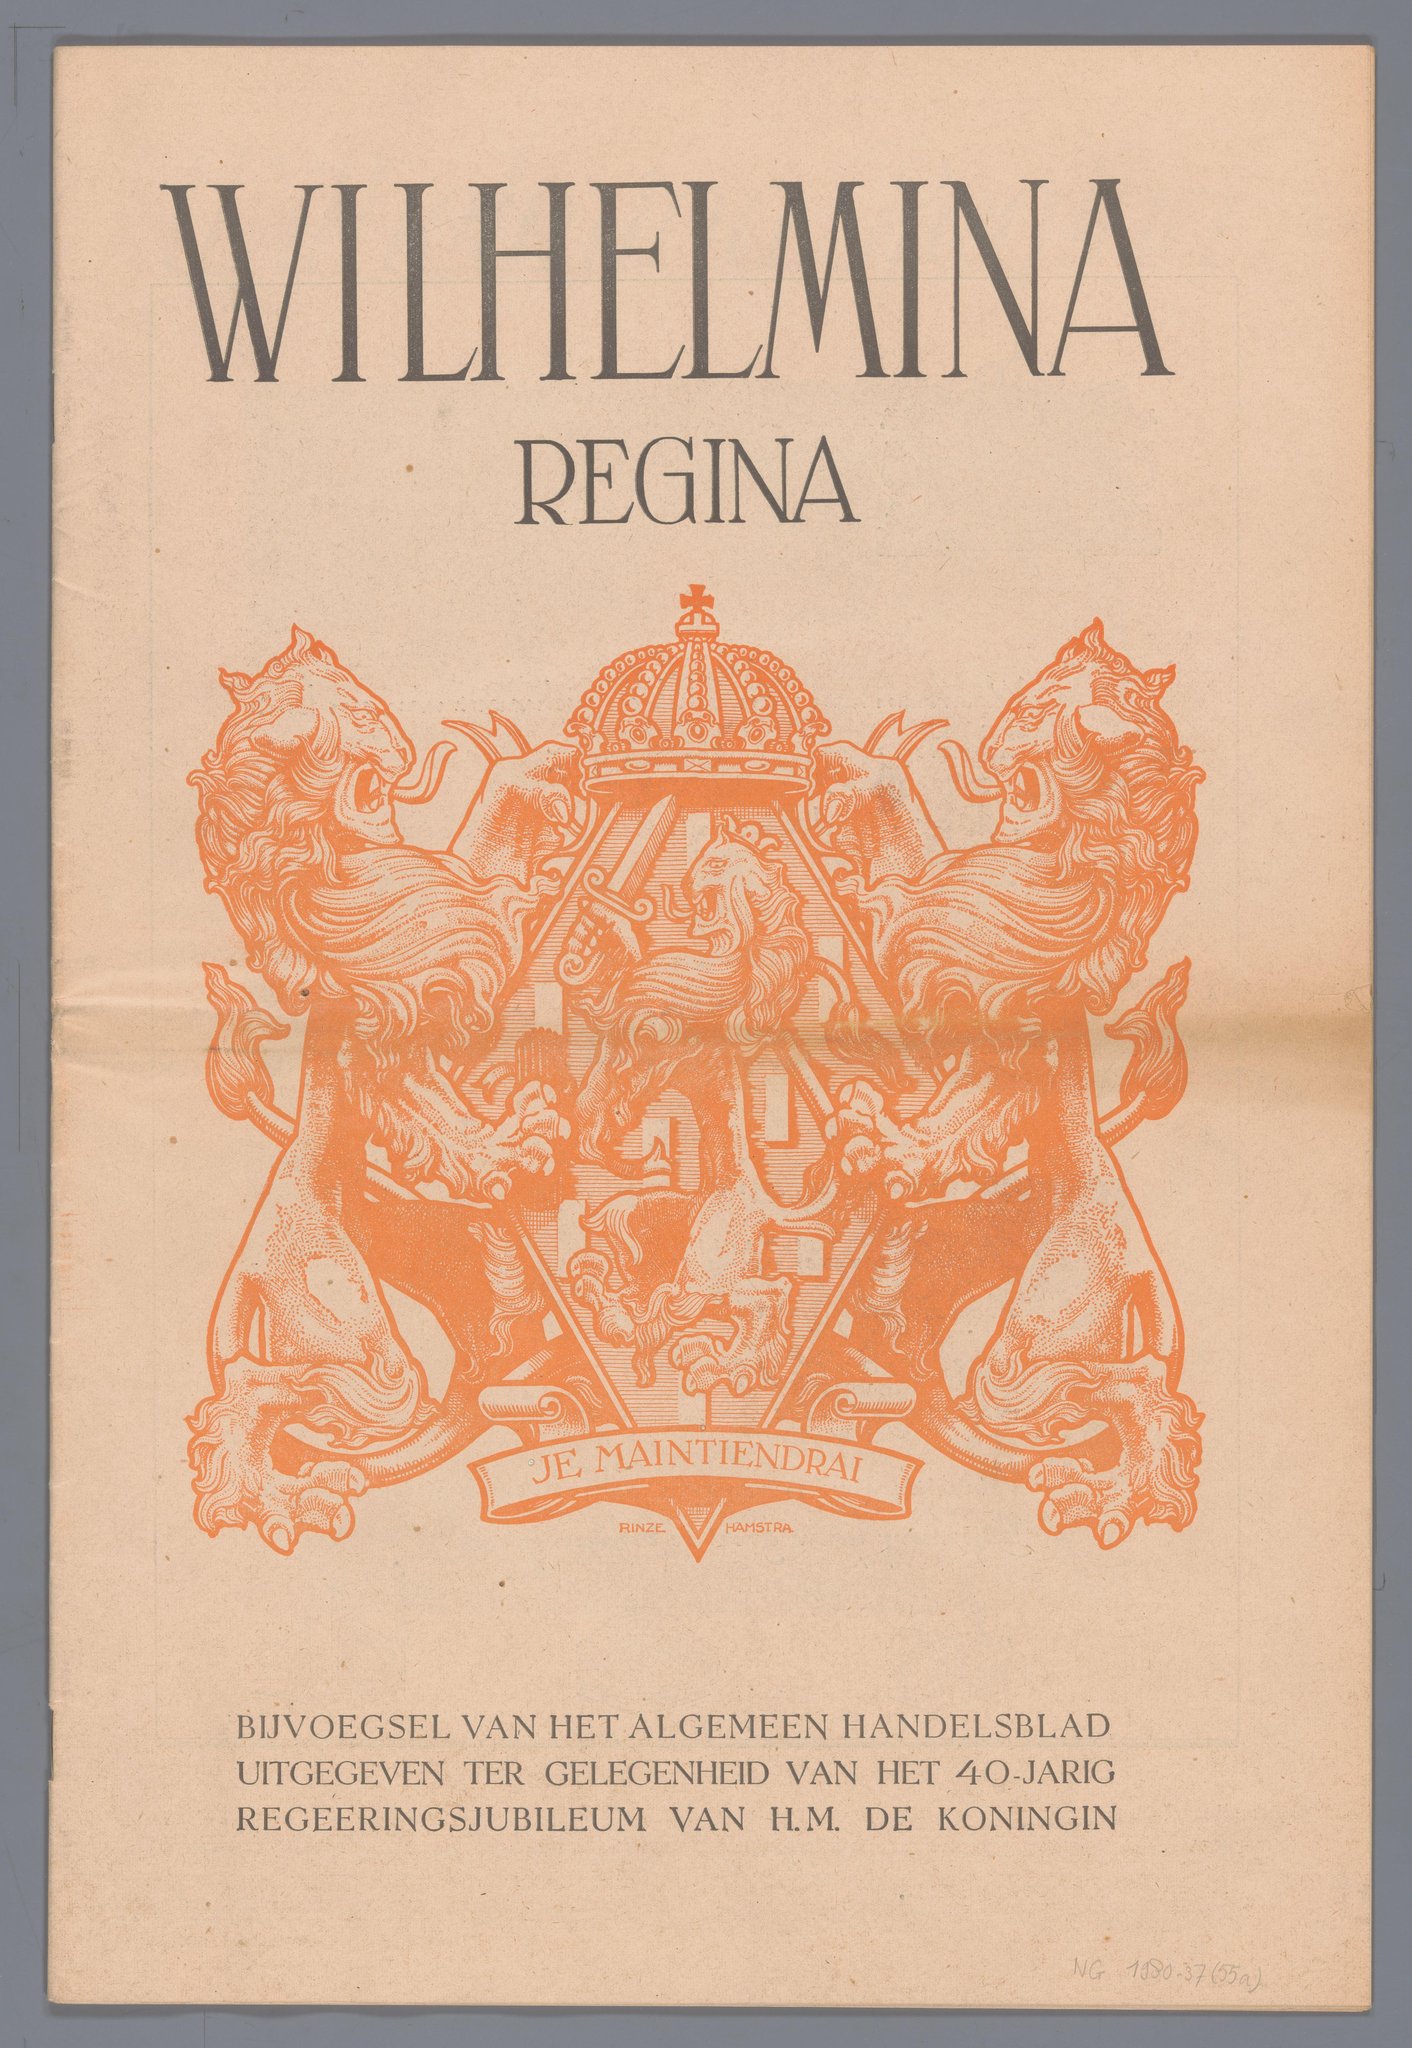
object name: newspaper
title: Wilhelmina Regina / Algemeen Handelsblad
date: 1938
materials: paper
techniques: printing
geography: amsterdam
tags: the hague, print maker, wilhelmina of the netherlands, netherlands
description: Krant. Algemeen Handelsblad 111 jaargang, bijvoegsel nr. 36495, 42 genummerde pp.